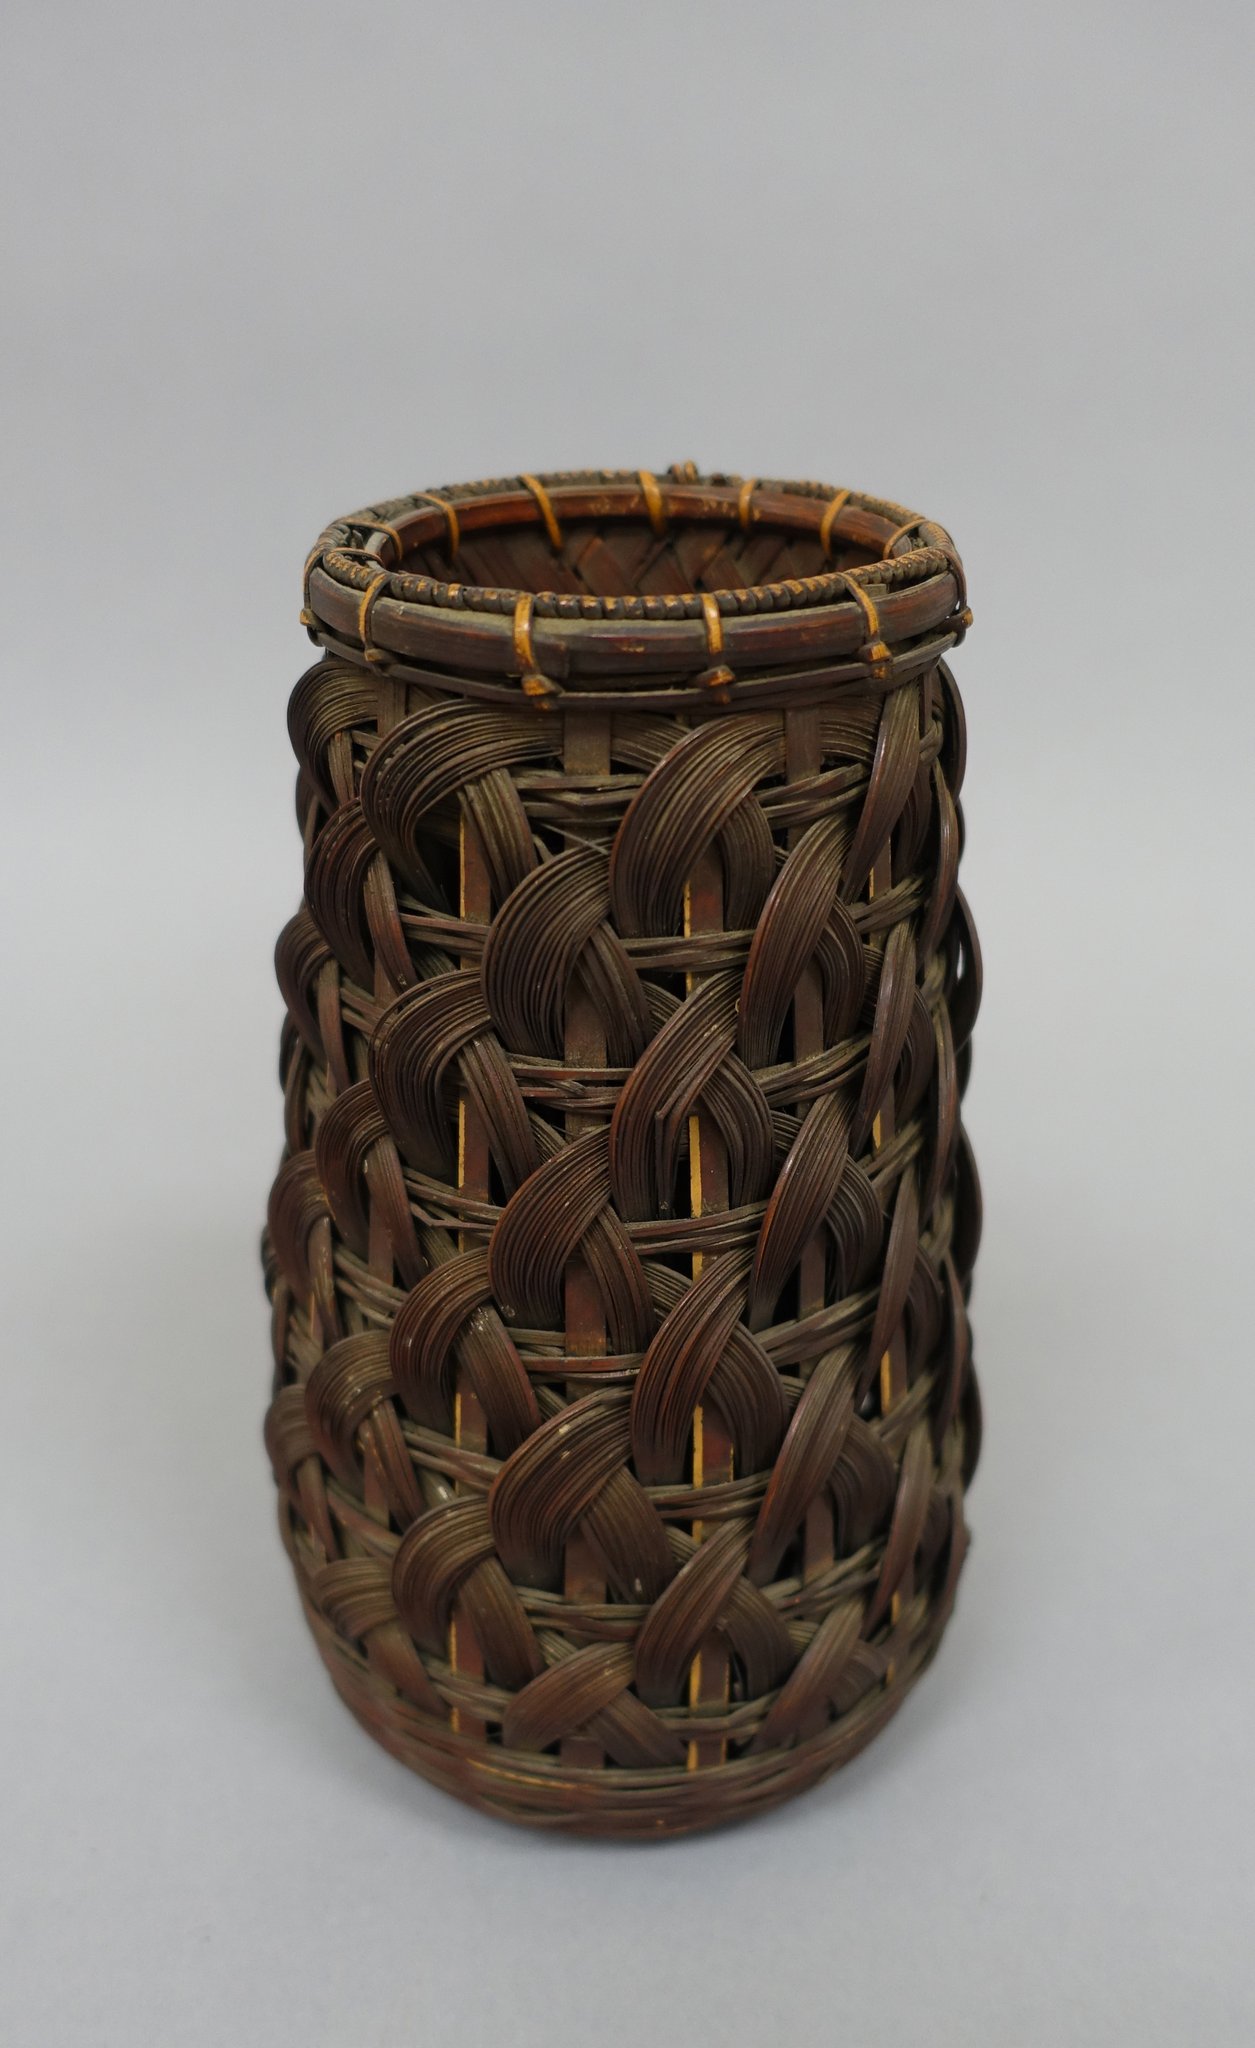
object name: basket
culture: japanese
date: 1801-1900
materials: bamboo